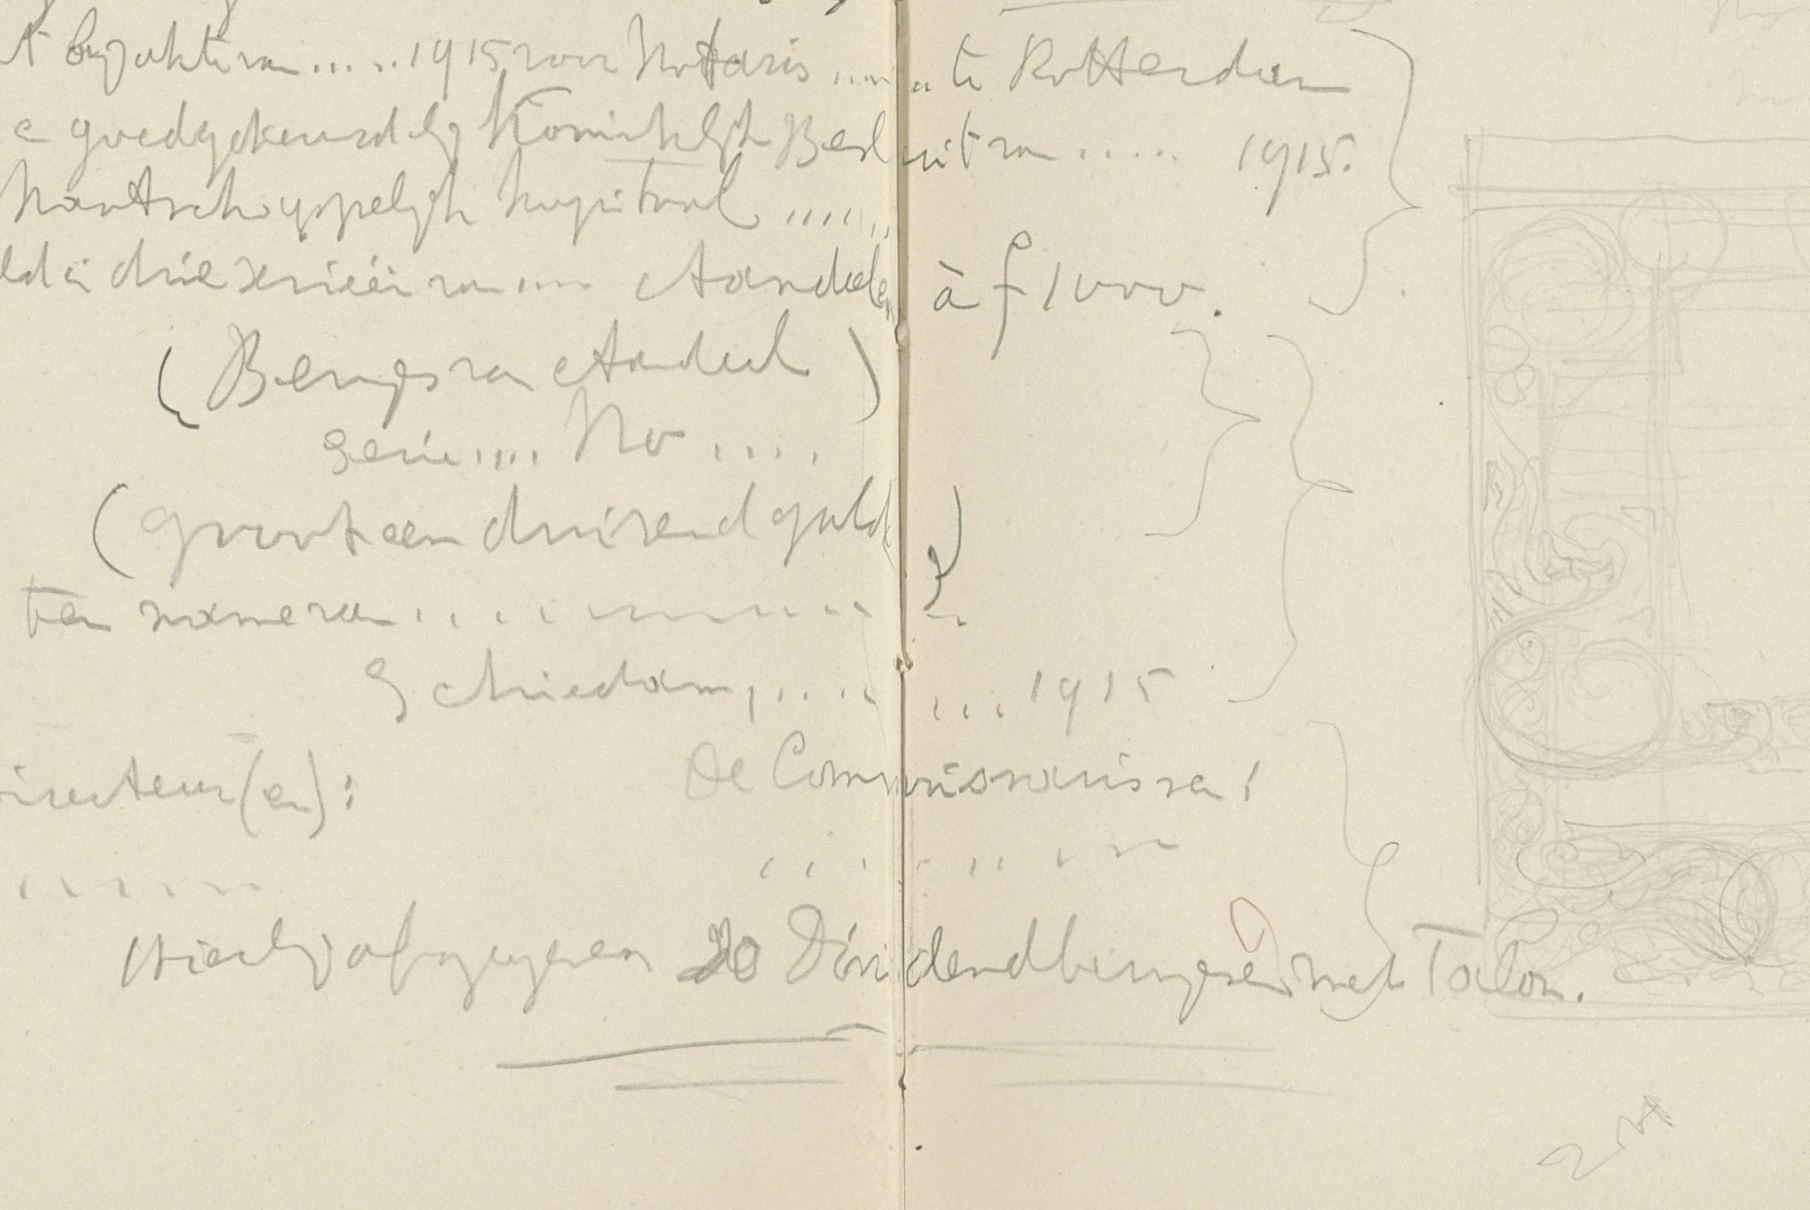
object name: sketchbook leaf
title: Decoratief ontwerp voor de Tegelfabriek Schiedam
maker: reijer stolk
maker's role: draughtsman, print maker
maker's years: 1896-1945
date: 1906-1945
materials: paper, pencil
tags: ornaments ~ art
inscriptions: annotation: ‘Naamloos Vennootschap/ "Tegelfabriek Schiedam",/ gevestigd te Schiedam./ opgericht bij akte van .... 1915 voor notaris....te Rotterdam/ [...]’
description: Blad 51 verso en 52 recto uit een schetsboek met 69 bladen.